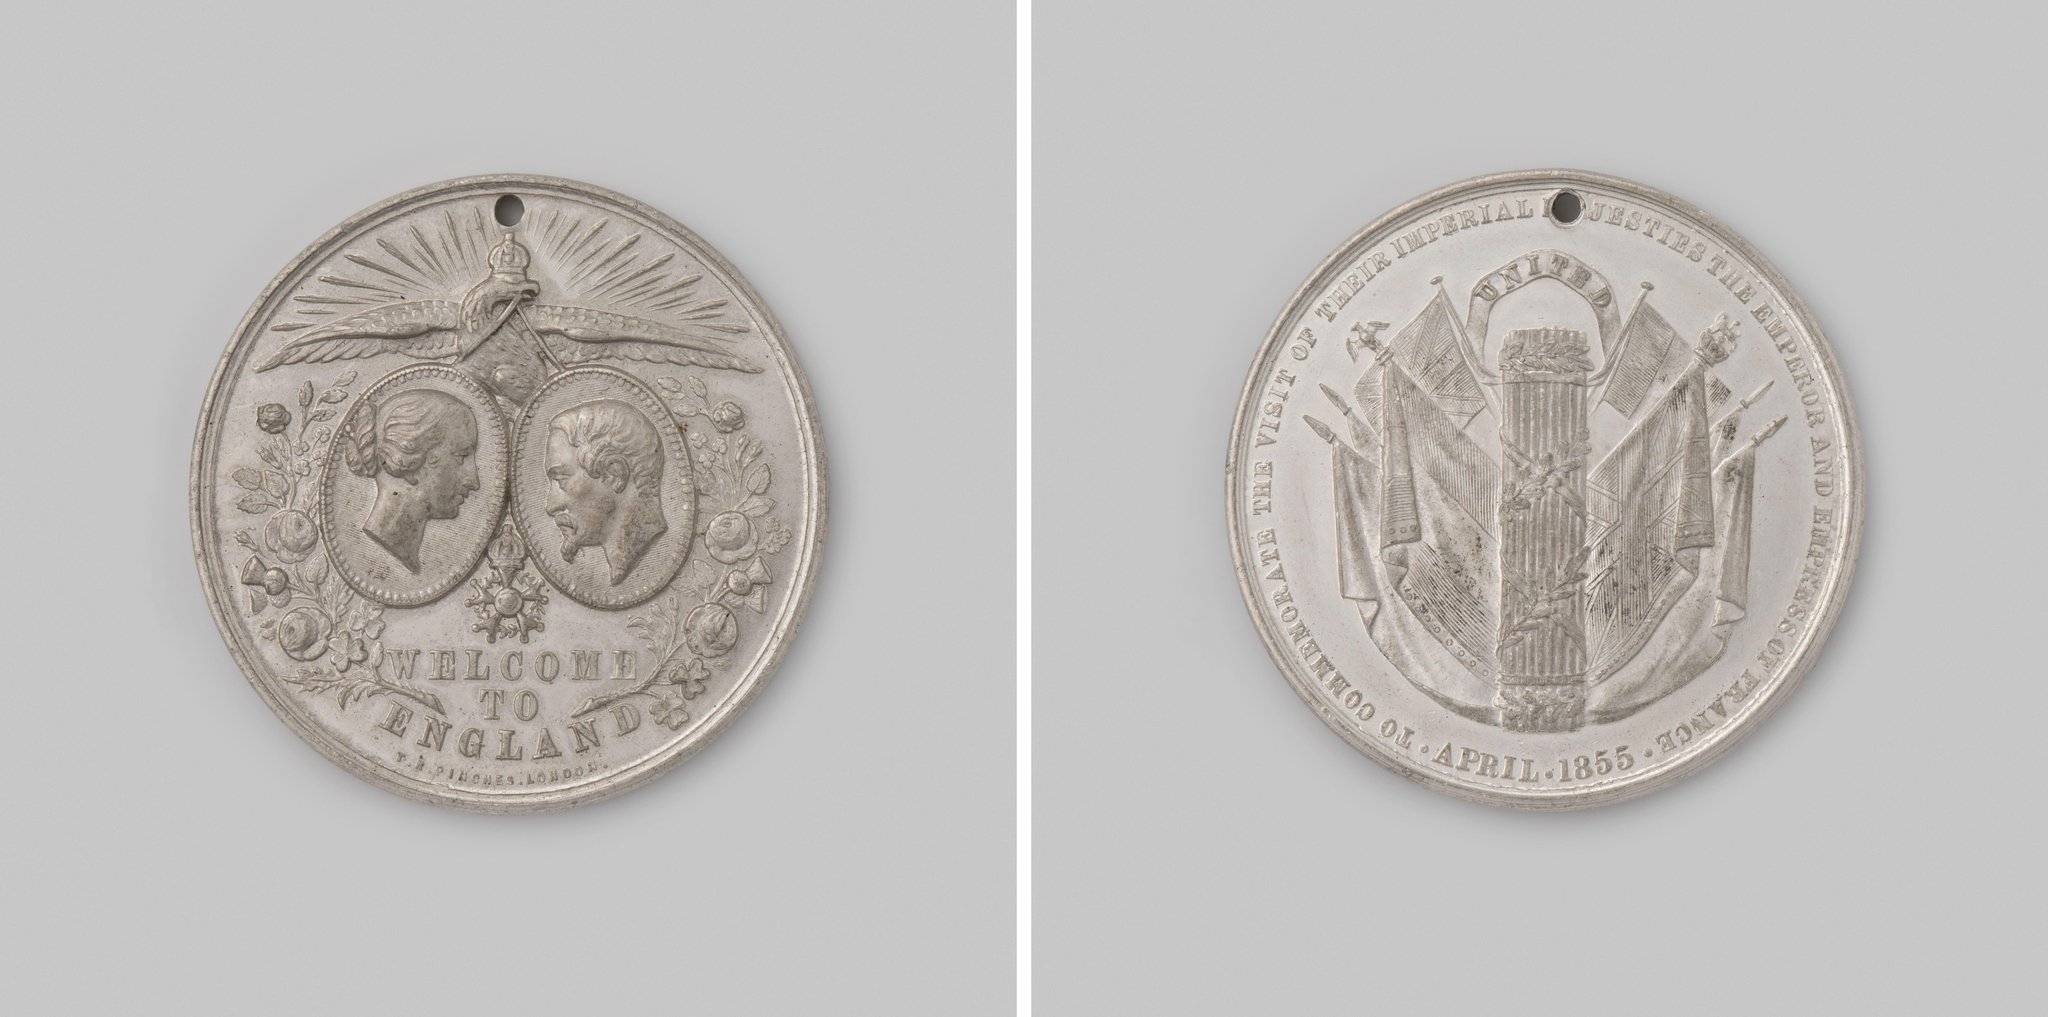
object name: history medal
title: Bezoek van Keizer Napoleon III en Keizerin Eugenie aan Engeland 1855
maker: thomas ryan pinches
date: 1855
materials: tin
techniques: striking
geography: london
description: Tinnen penning, op de voorzijde een stralende gekroonde adelaar met aan een lint twee ovale medaillons met de portretten van Koningin Victoria en Napoleon III, waaronder drie regels tekst tussen bloemtakken, op de keerzijde een bundel vlaggen, de Franse en de Engelse met een lint verbonden, waarvoor een fasces, met omschrift.